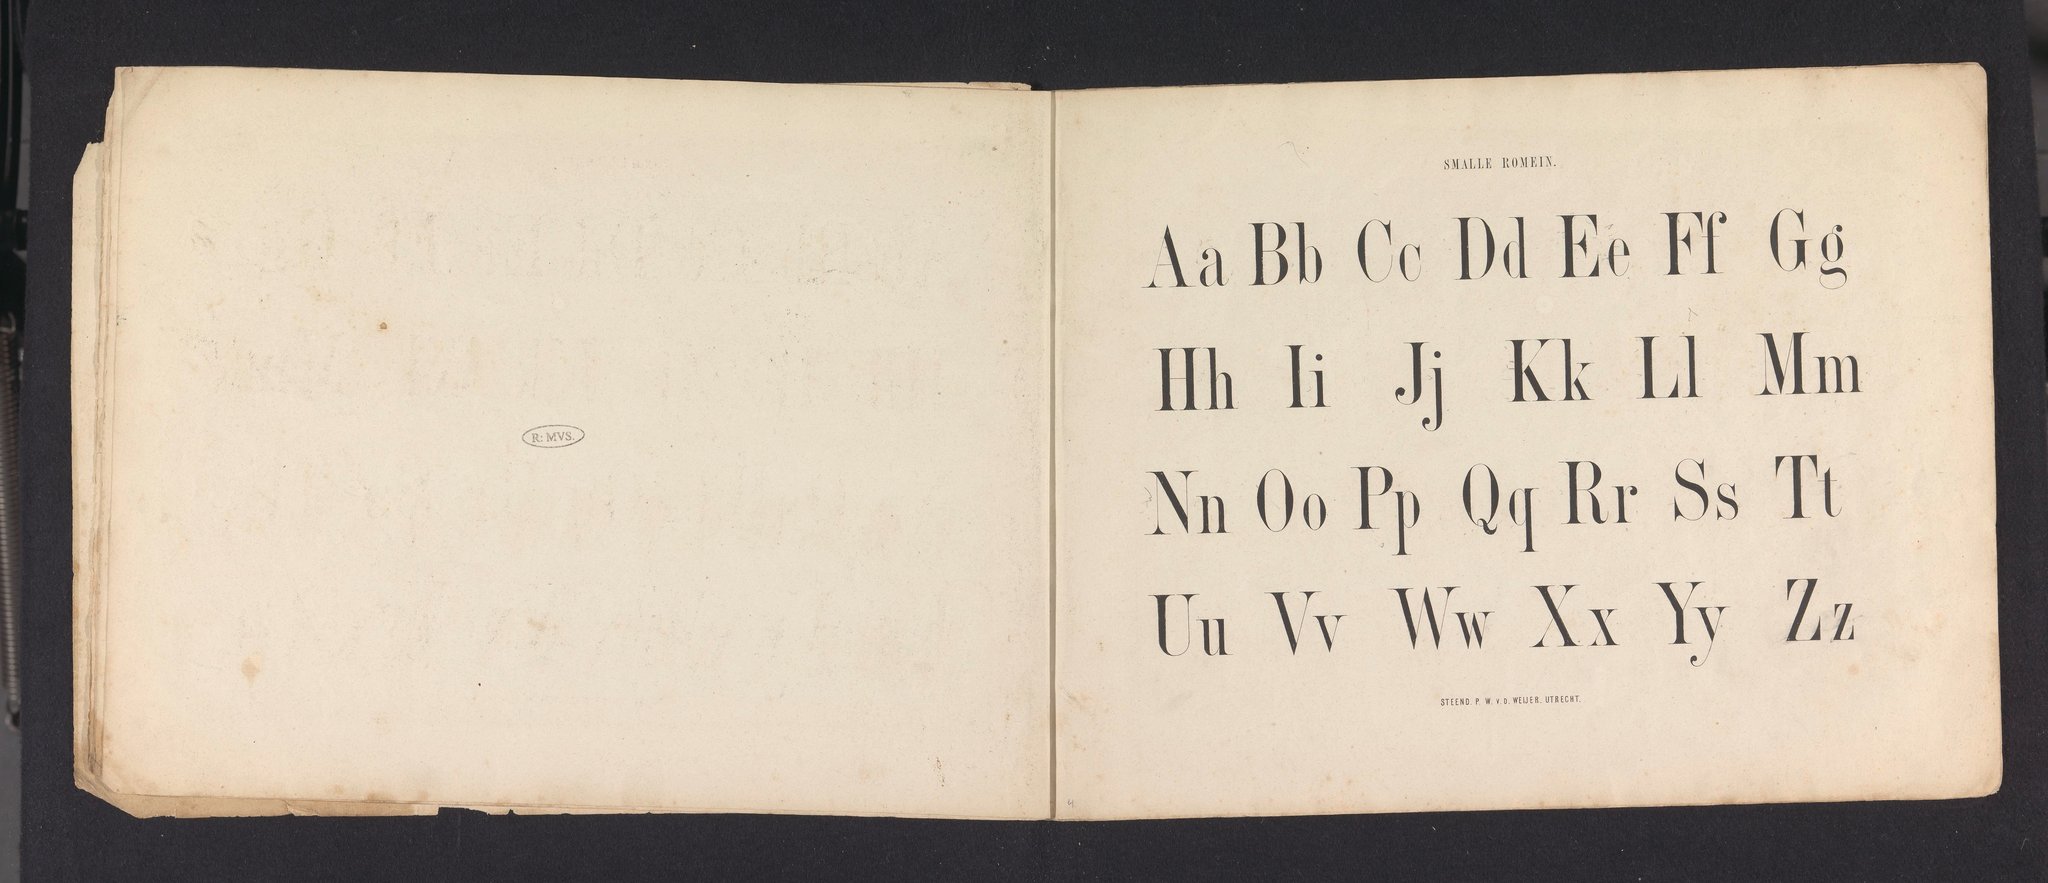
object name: print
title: Smalle romein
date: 1855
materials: paper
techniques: lithograph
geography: utrecht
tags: letters, alphabet, script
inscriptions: collector's mark: Lugt 2228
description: De prent maakt onderdeel uit van een album.